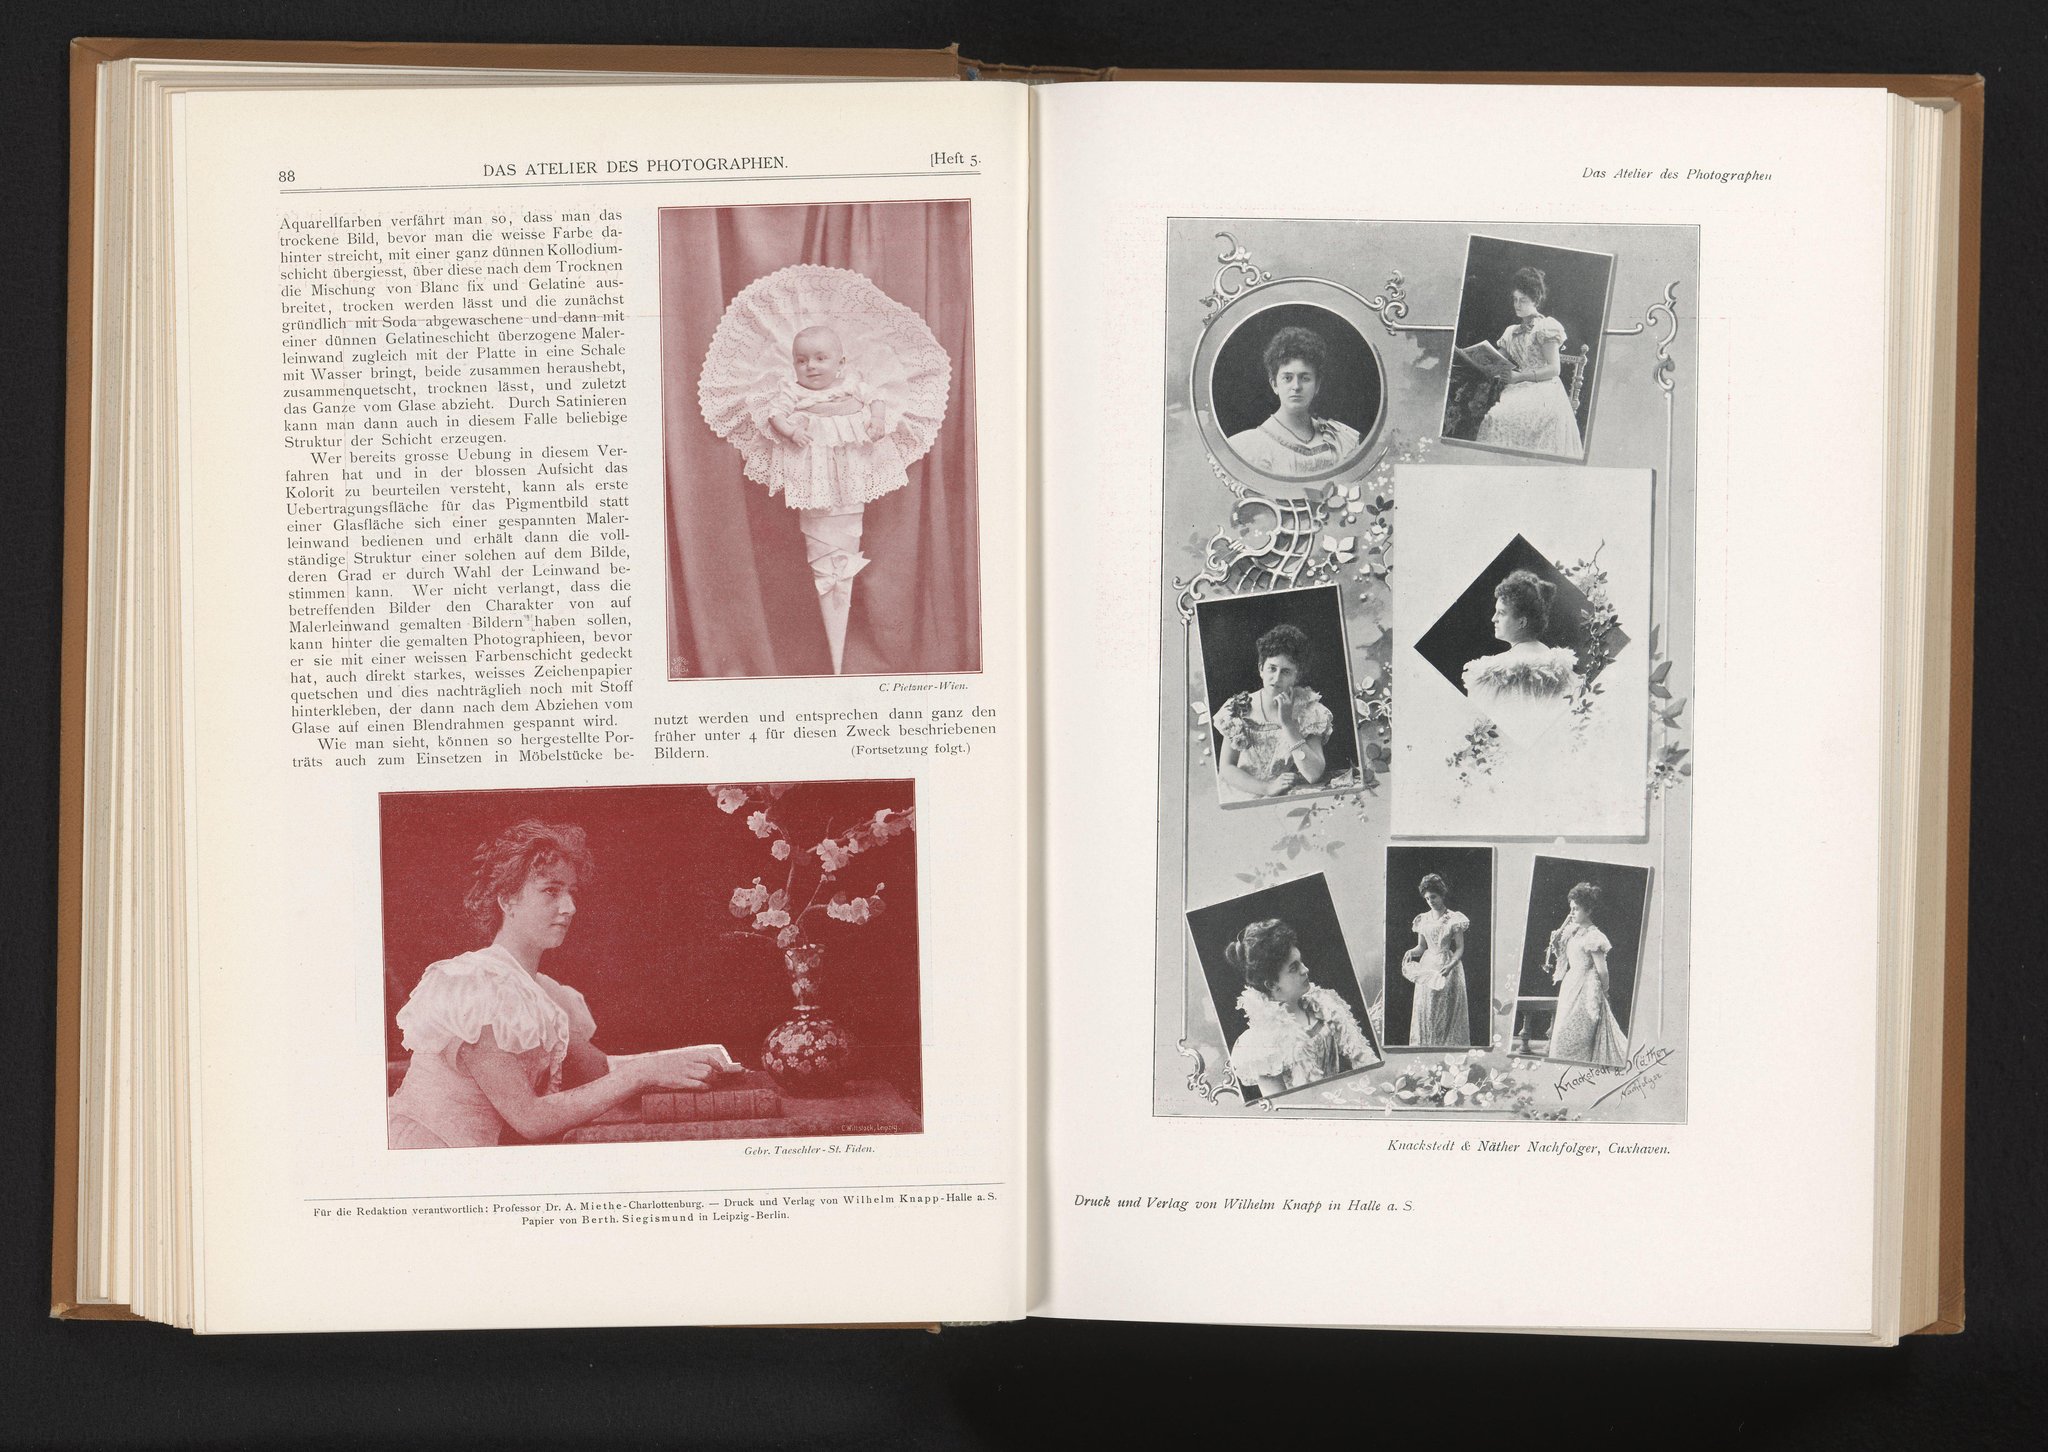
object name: photomechanical print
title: Collage van zeven portretten van een onbekende vrouw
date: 1895-1900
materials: paper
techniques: autotype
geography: halle an der saale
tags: historical persons - bb - woman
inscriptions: inscription: ‘Das Atelier des Photographen.’, monogram: ‘LEIPZIG/ S G’